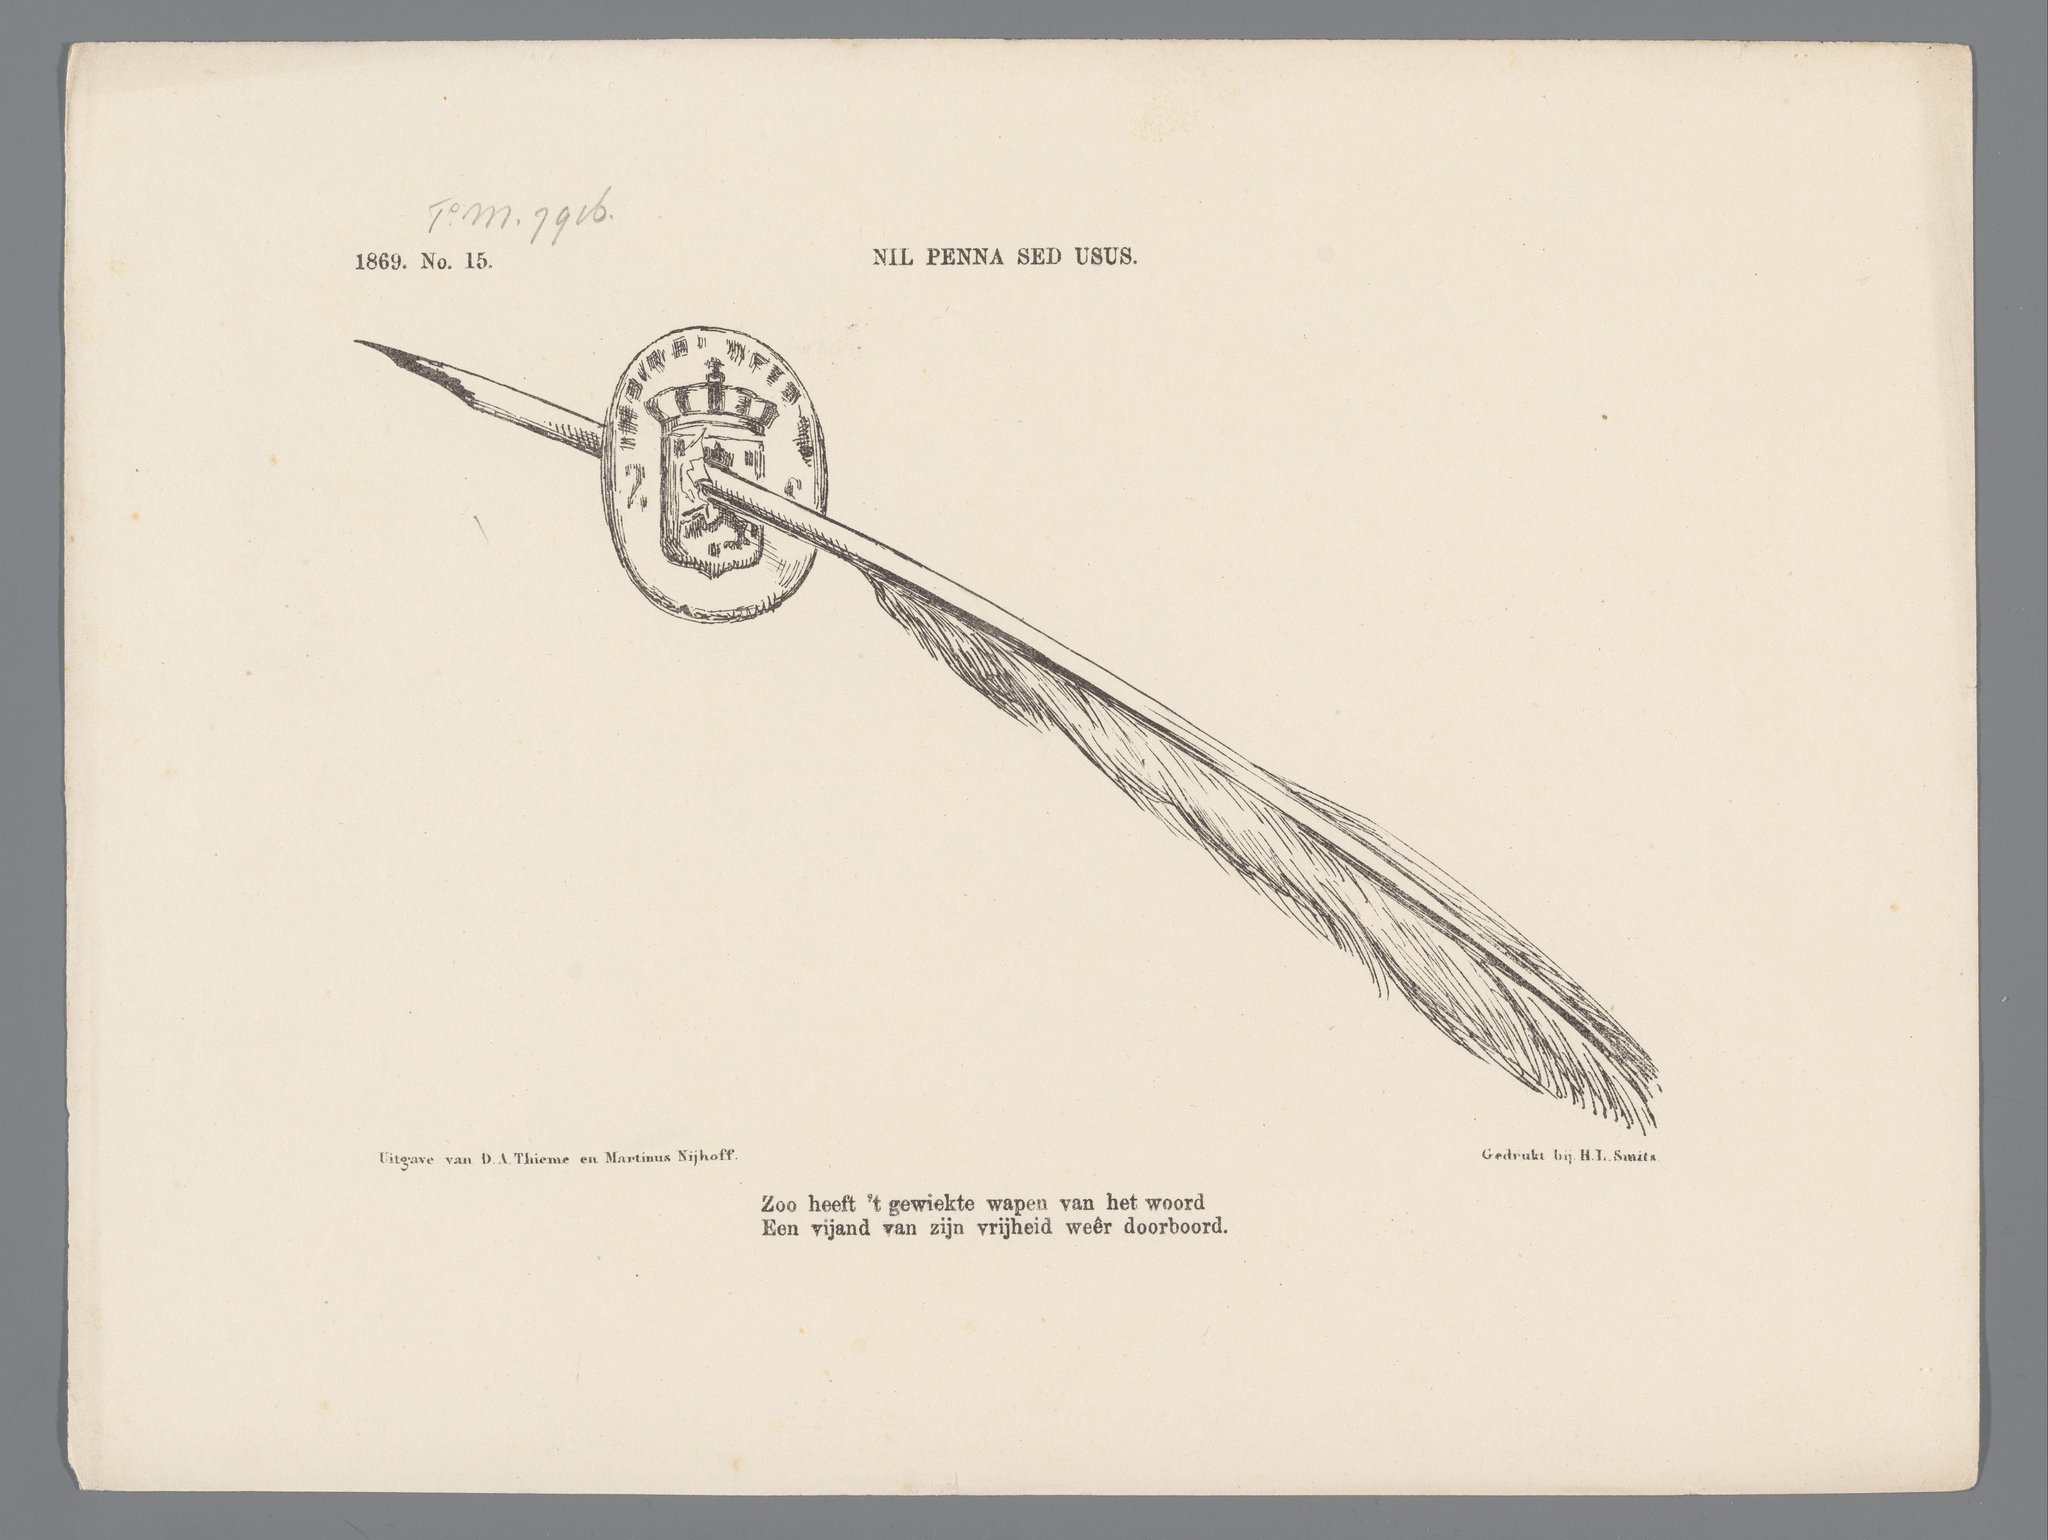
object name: print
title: Spotprent over de afschaffing van het dagbladzegel, 1869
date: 1869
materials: paper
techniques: lithograph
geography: netherlands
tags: quill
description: Spotprent over de rol die het geschreven woord heeft gespeeld in de afschaffing van het dagbladzegel. Plaat verschenen bij het weekblad De Nederlandsche Spectator, nr. 15, 1869.